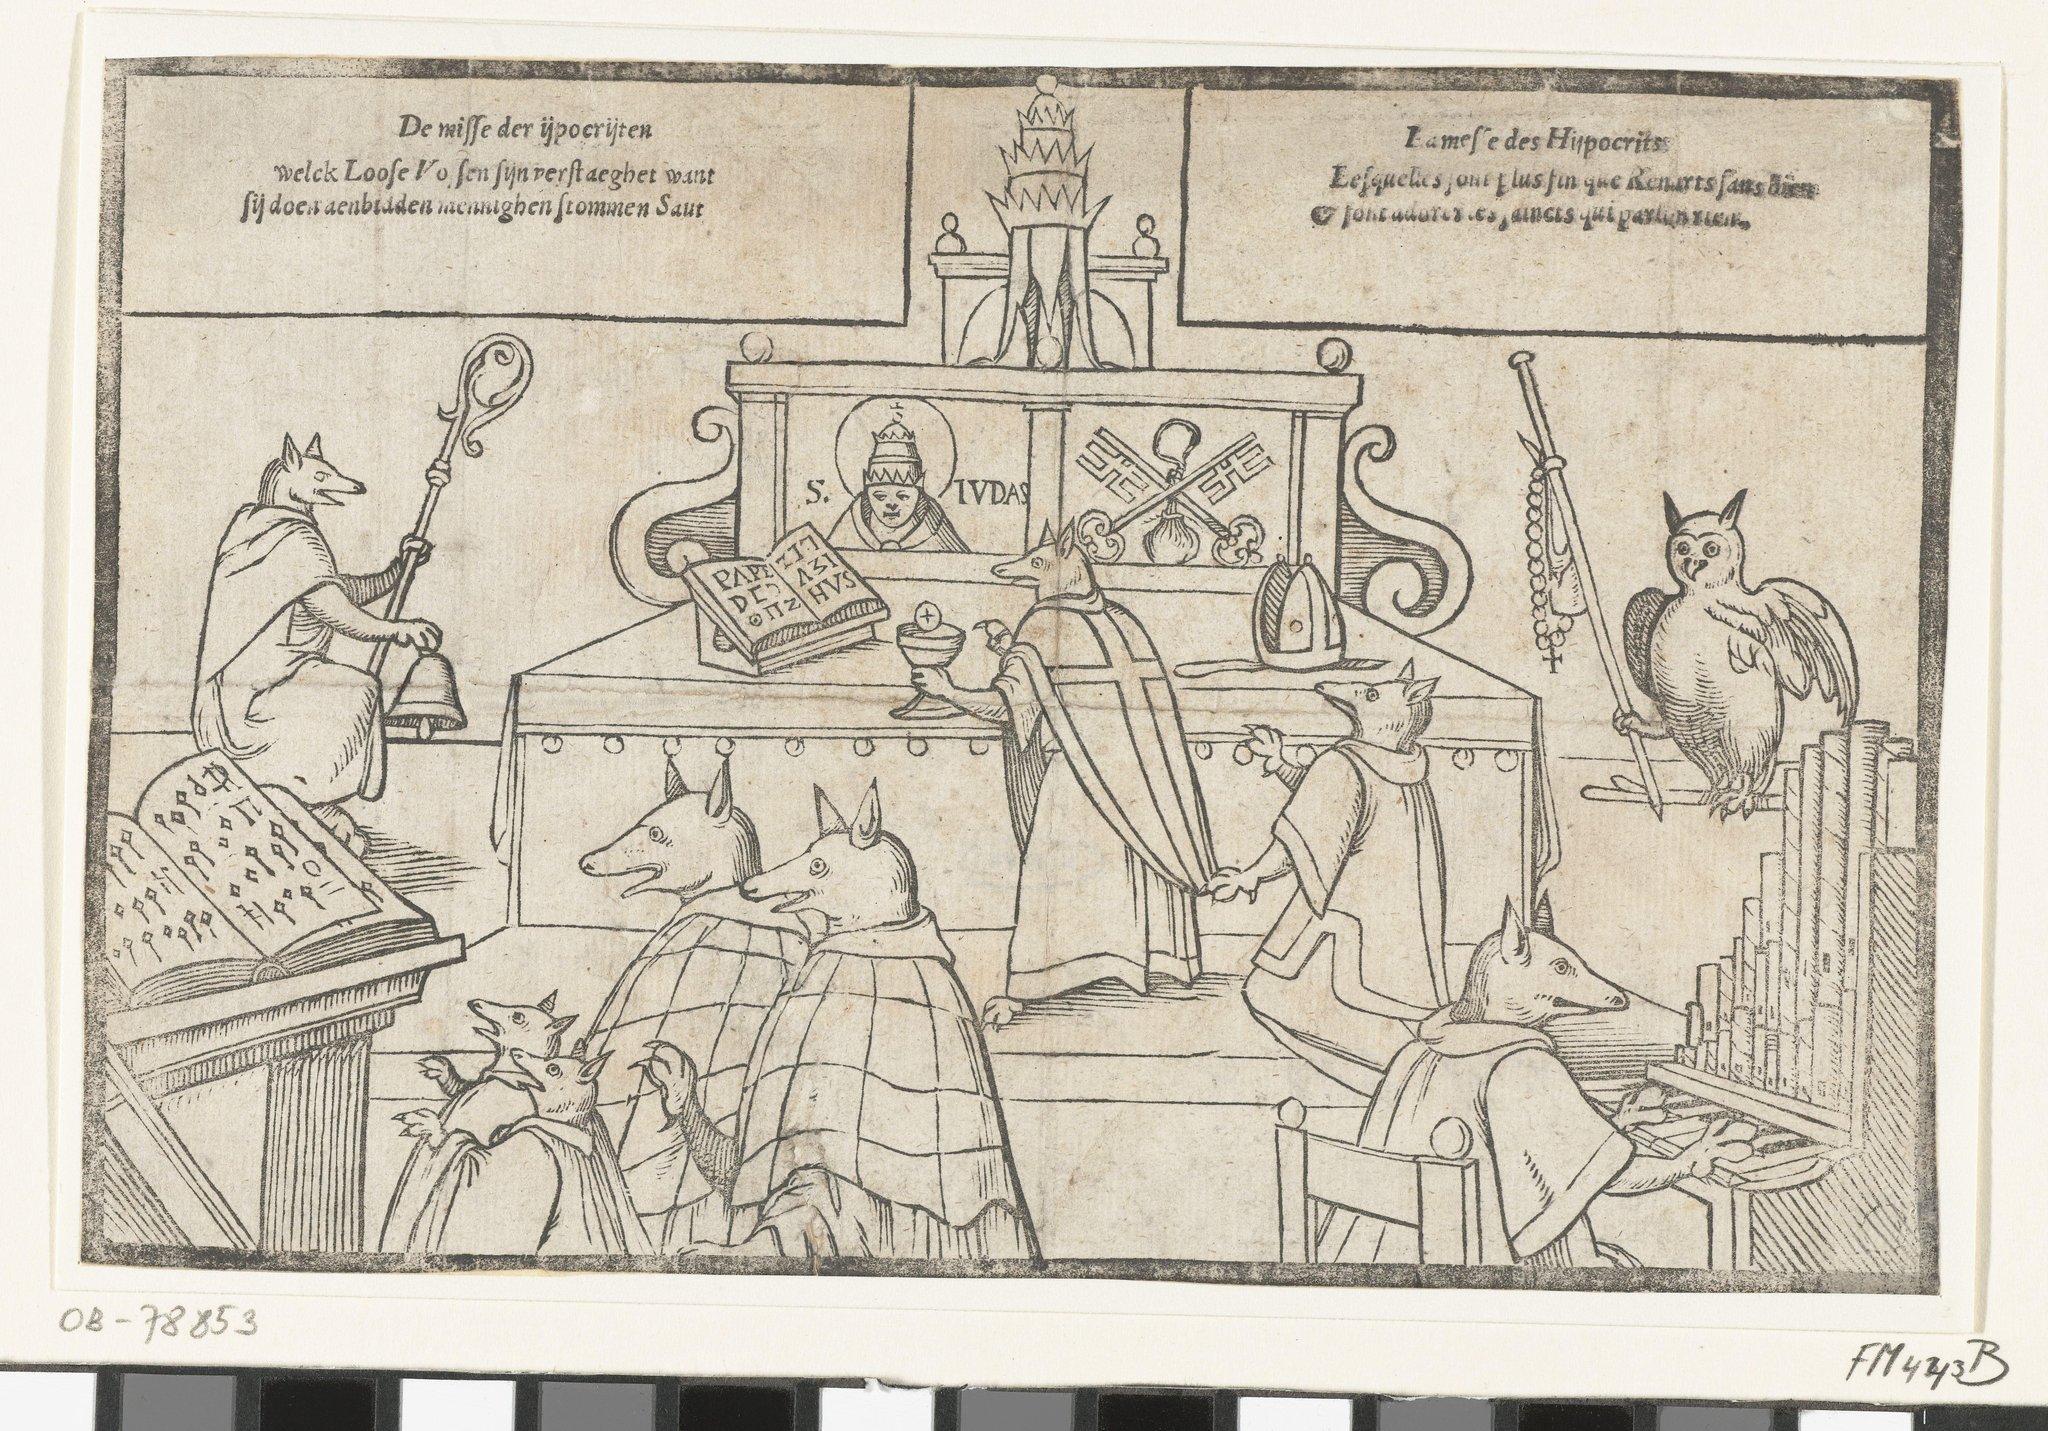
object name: cartoon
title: De misse der ijpocrijten / La messe des Hijpocrits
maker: Anonymous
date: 1566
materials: paper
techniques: letterpress printing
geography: low countries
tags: reformation (roman catholic church vs. protestantism), holy mass (divine service, especially of roman catholic church)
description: De mis der hypocrieten. De Roomse mis wordt opgedragen door vossen in de rollen van de priester en misdienaren. Op het altaar een afbeelding van Sint Judas en de symbolen van de paus. Op de voorgrond links zingende vossen, rechts speelt een vos orgel. Rechts een uil op een stokje met een staf met rozenkrans. Boven 2 cartouches met elk 3 regels in het Nederlands en in het Frans. Spotprent op de mis en de Roomse kerk, ca. 1560.